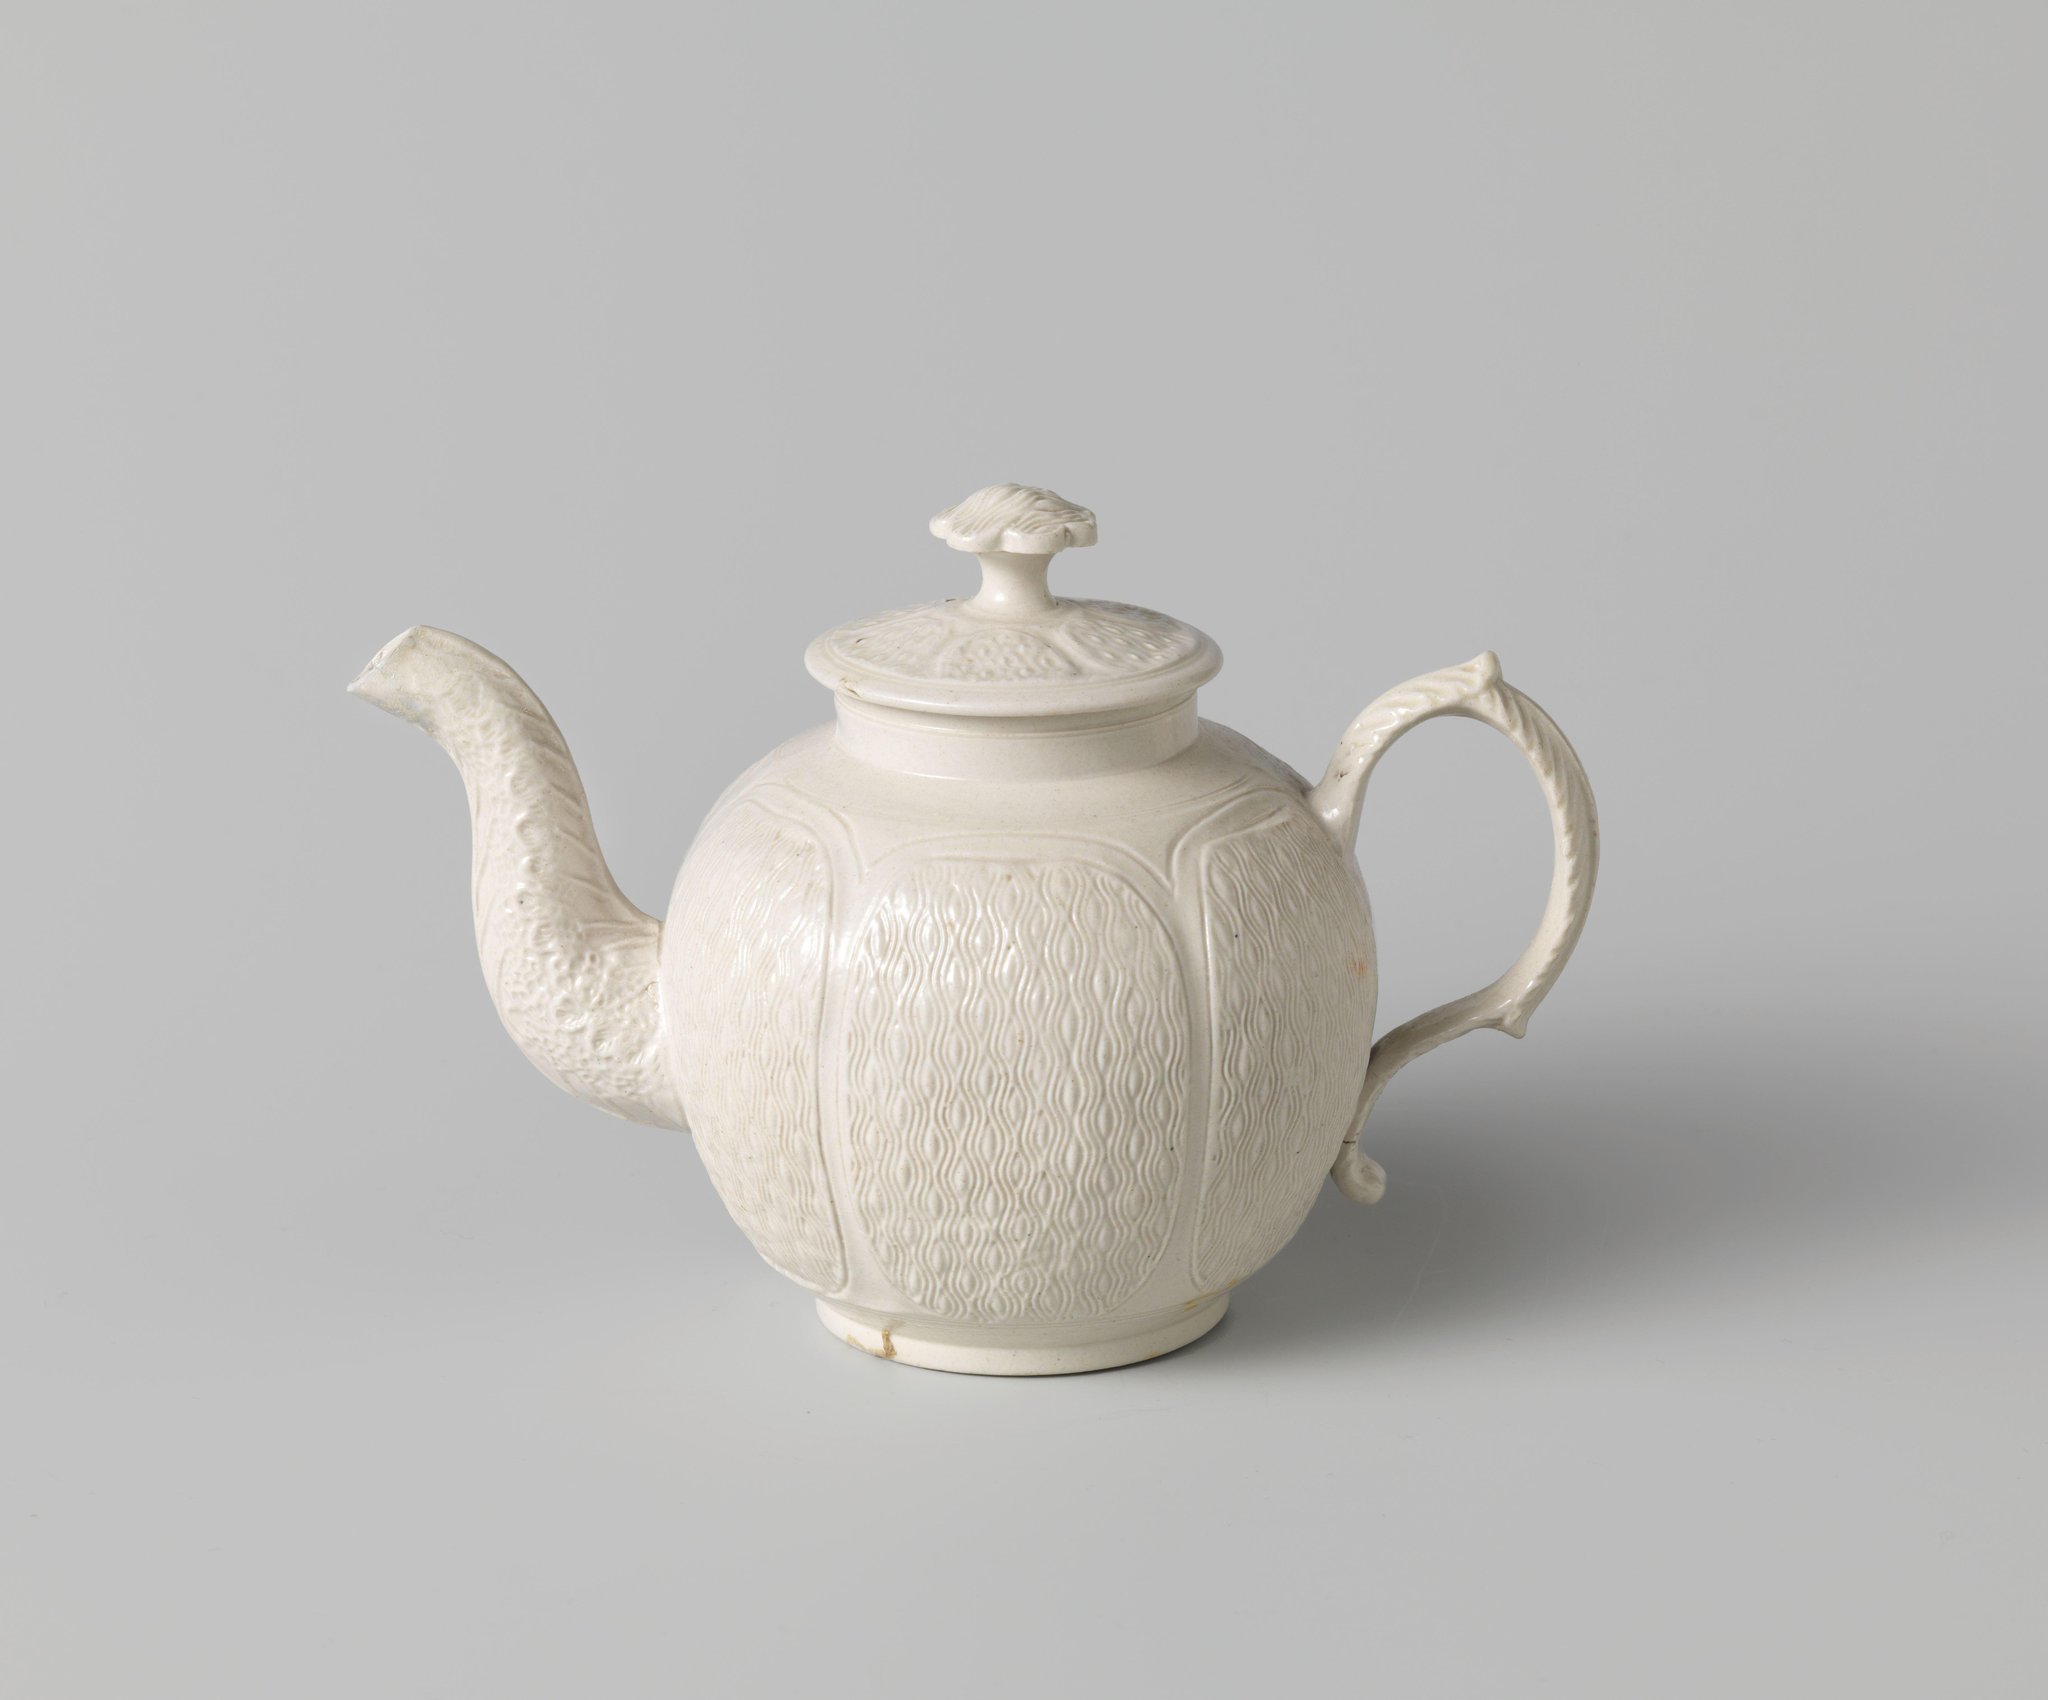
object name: teapot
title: Deksel van theepot van wit steengoed met reliëf versieringen; Staffordshire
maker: Anonymous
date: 1750-1765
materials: stoneware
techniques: salt glaze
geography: england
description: Het deksel heeft een bloem (?) als knop.